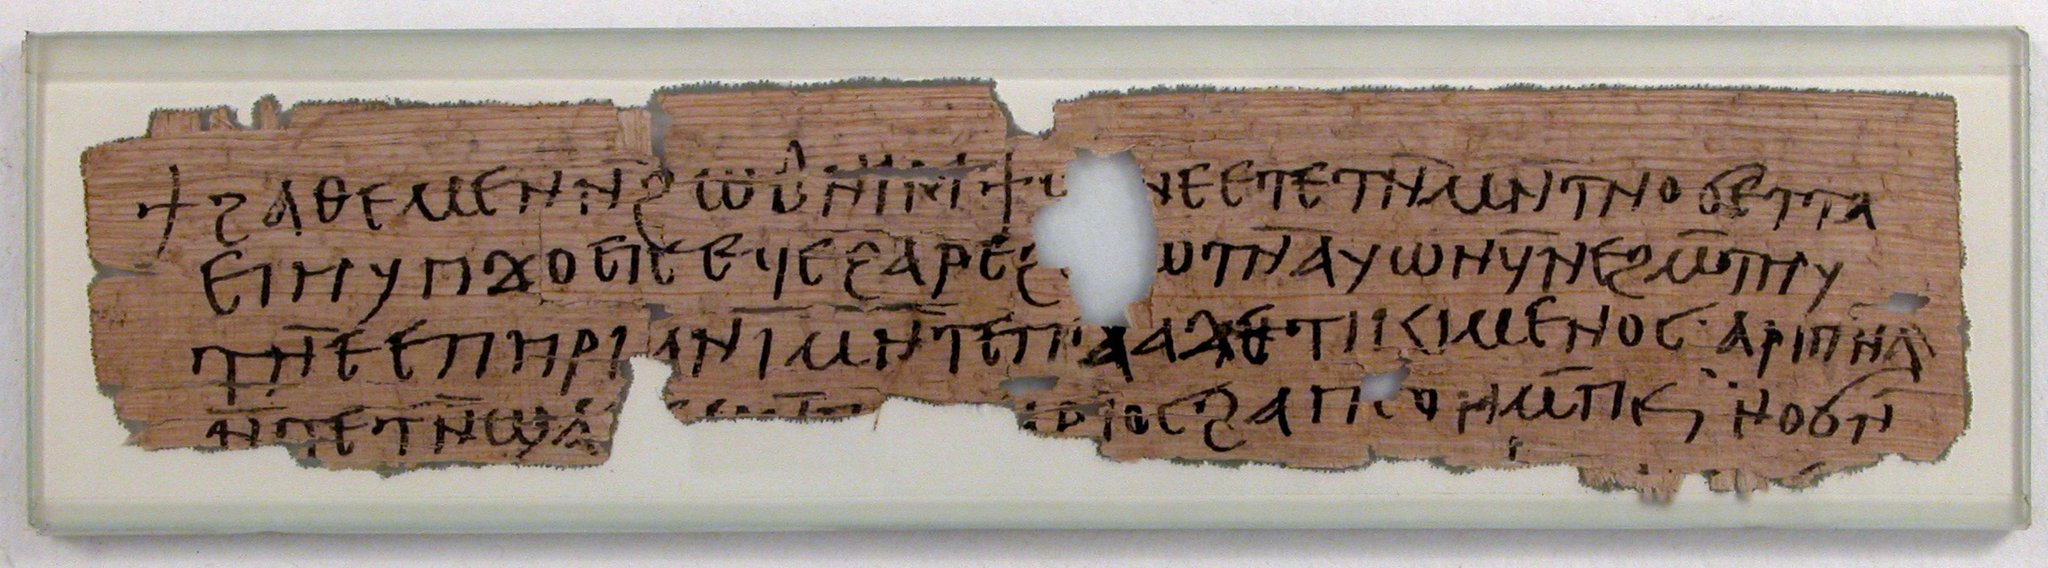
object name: papyrus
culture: coptic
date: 601-700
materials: ink, papyrus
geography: egypt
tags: documents